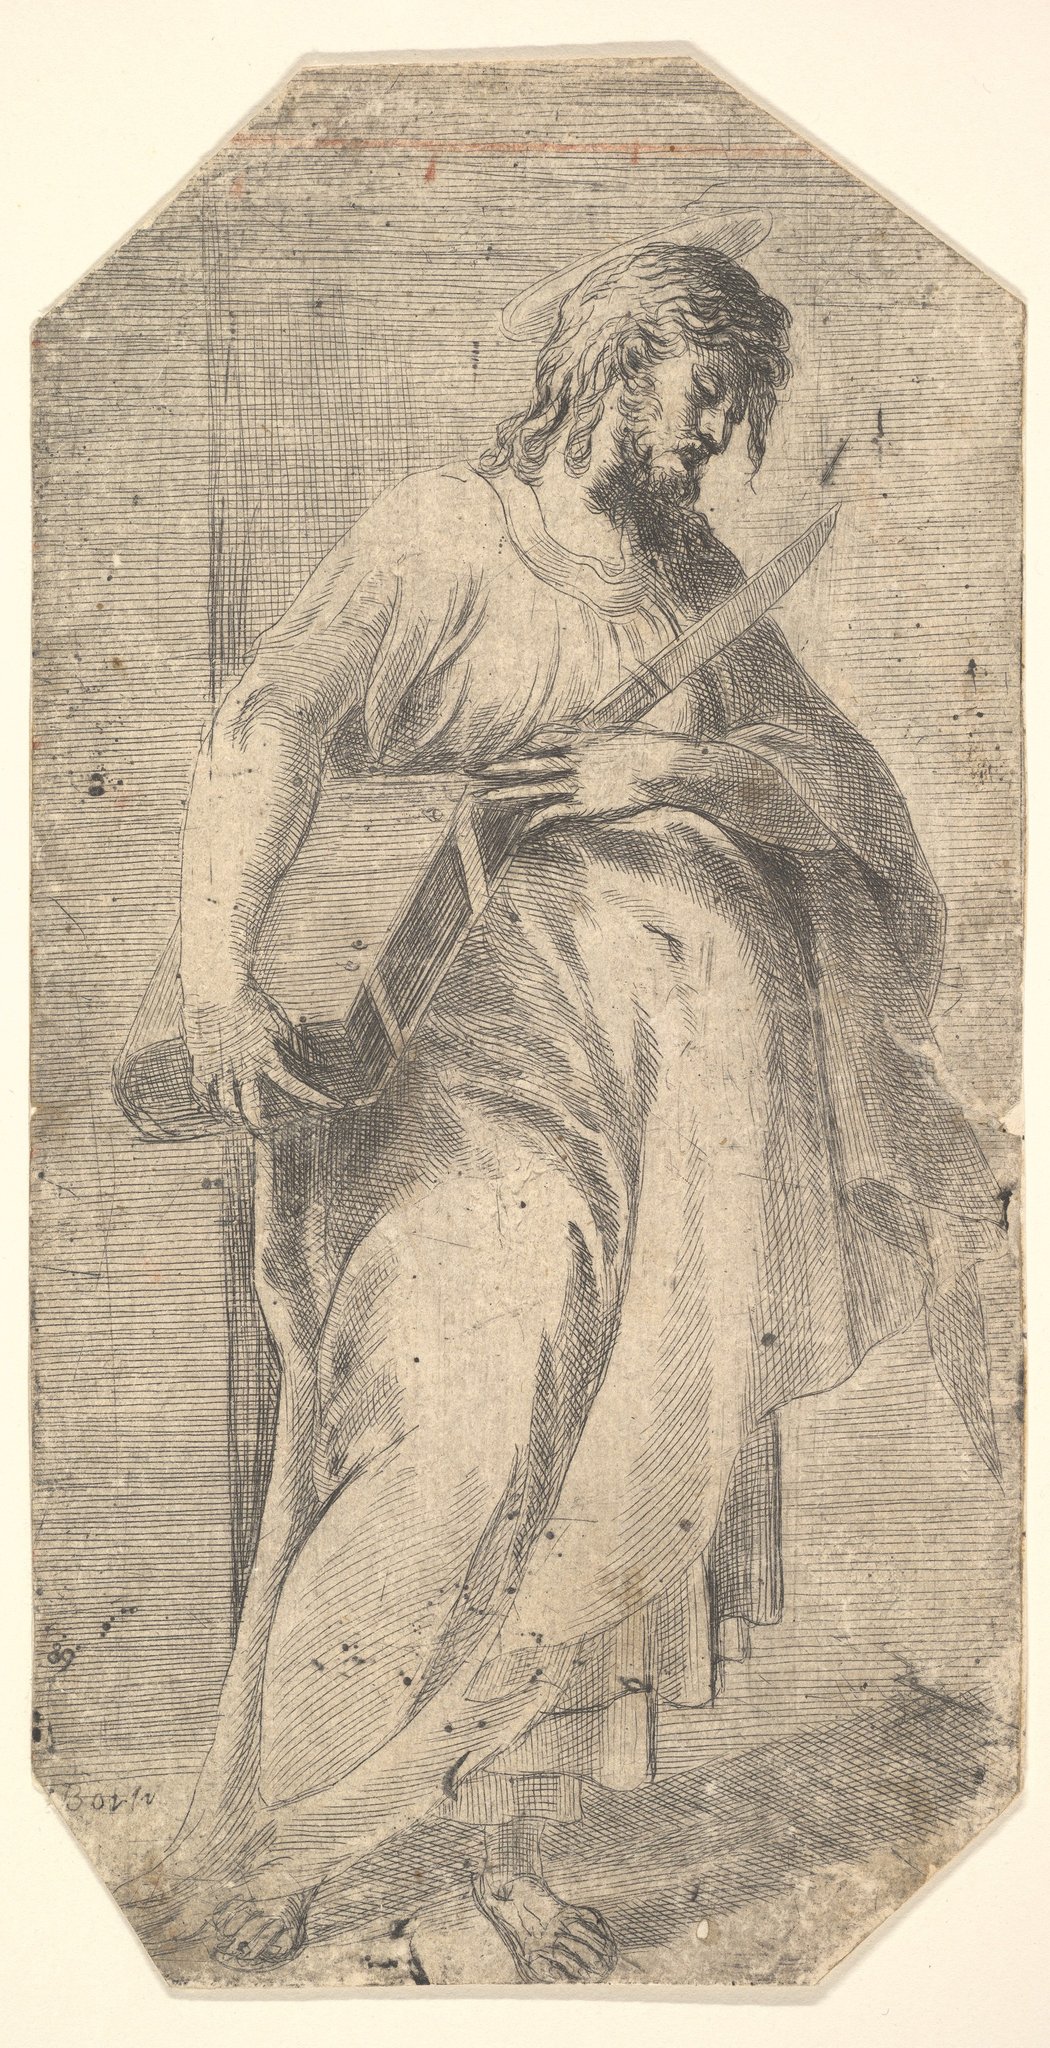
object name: print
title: Saint Bartholomew facing right, book under his right arm, knife in his left hand, from "Christ and the Apostles"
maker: andrea schiavone (andrea meldola)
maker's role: artist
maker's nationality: italian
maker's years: 1510-1563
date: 1548-1550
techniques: etching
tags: books,knives,apostles,saints